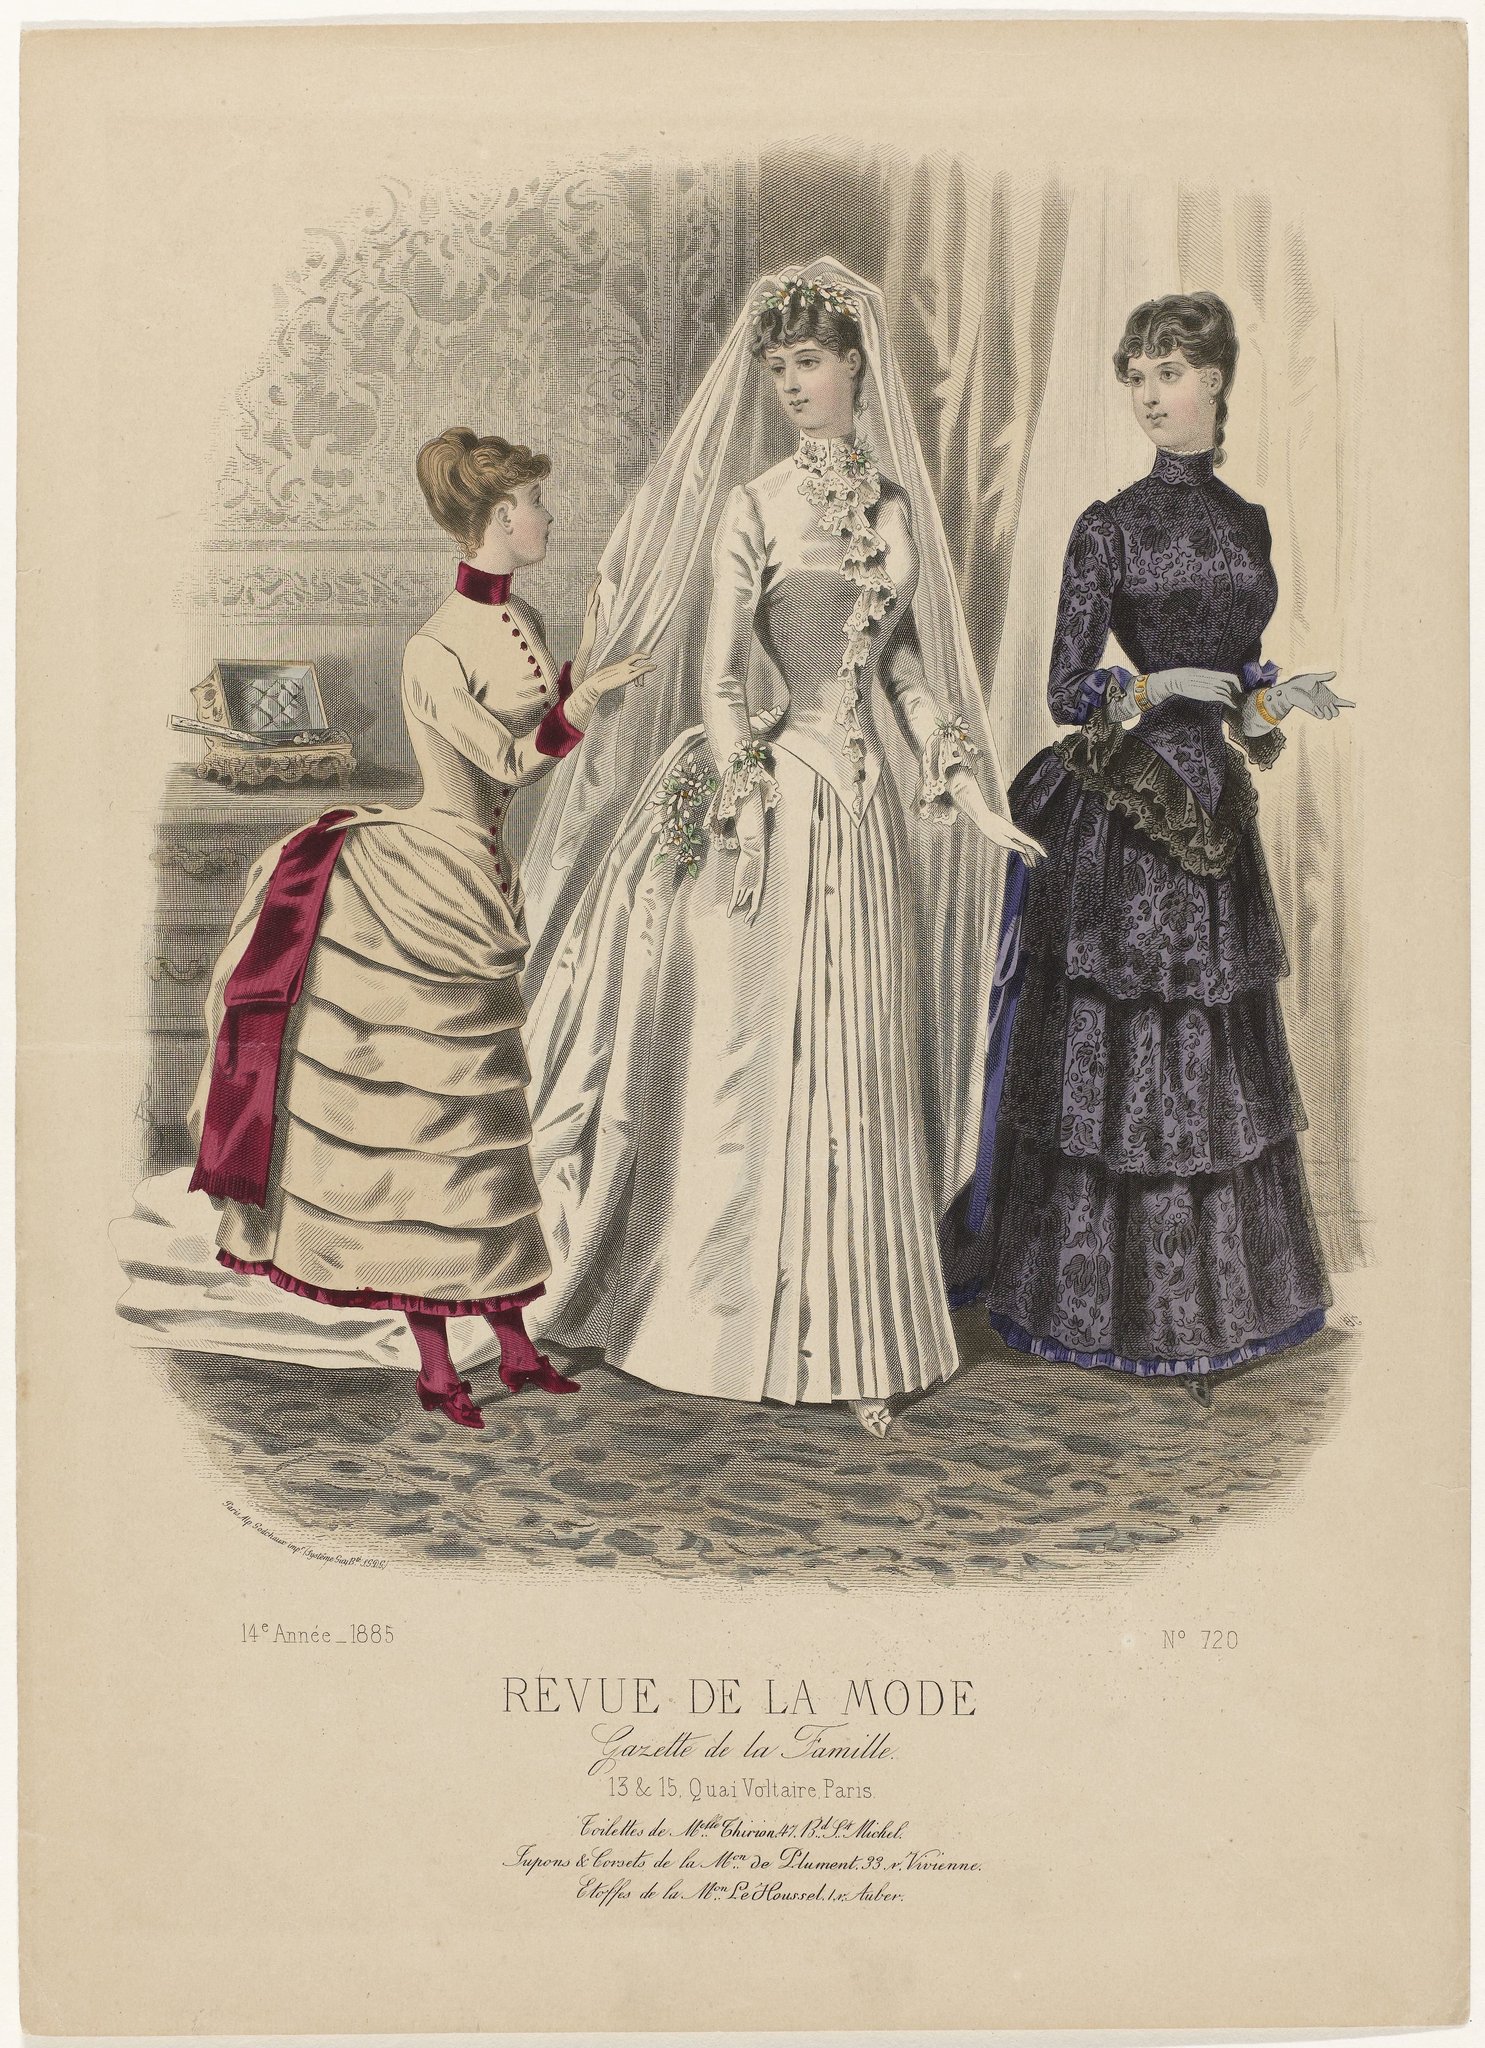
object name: fashion print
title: Revue de la Mode, Gazette de la Famille, dimanche 18 octobre 1885, 14e Année, No. 720: Toilettes de M.elle Thirion (...)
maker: Anonymous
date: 1885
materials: paper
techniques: engraving, hand coloring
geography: paris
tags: corsage (+ women's clothes), flowers, gloves, mittens (long gloves) (+ women's clothes), veil (+ women's clothes), fashion plates, shoes, sandals (+ women's clothes), dress, gown (+ women's clothes), bride (in wedding-dress), fan (+ women's clothes), jewel-box, belt, girdle, waistband (+ women's clothes)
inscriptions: title: ‘REVUE DE LA MODE / Gazette de la Famille’, address: ‘13 & 15, Quai Voltaire Paris’, caption: ‘Toilettes de M.elle Thirion, 47, B.d S.t Michel. Jupons & Corsets de la M.on de Plument, 33, r. Vivienne. Etoffes de la M.on Le Houssel 1 r. Auber.’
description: Drie vrouwen in een interieur, in japonnen van Thirion. Links: japon van witte wol en granaatrode velours, geschikt voor een jonge vrouw van 15 jaar. Schoenen met hakken en strikken. Midden: bruidsjapon van witte faille. Bloemcorsages van oranjebloesem. Rechts: japon van paarse faille overtrokken met zwart kant. Aan de voorzijde van de rok drie kanten volants van 40 centimeter. Met enkele regels reclametekst voor verschillende producten. Prent uit het modetijdschrift Revue de la Mode (1872-1913). Uitgebreide beschrijving van de kleding op pagina 333 en 334 "PLANCHE COLORIÉE".